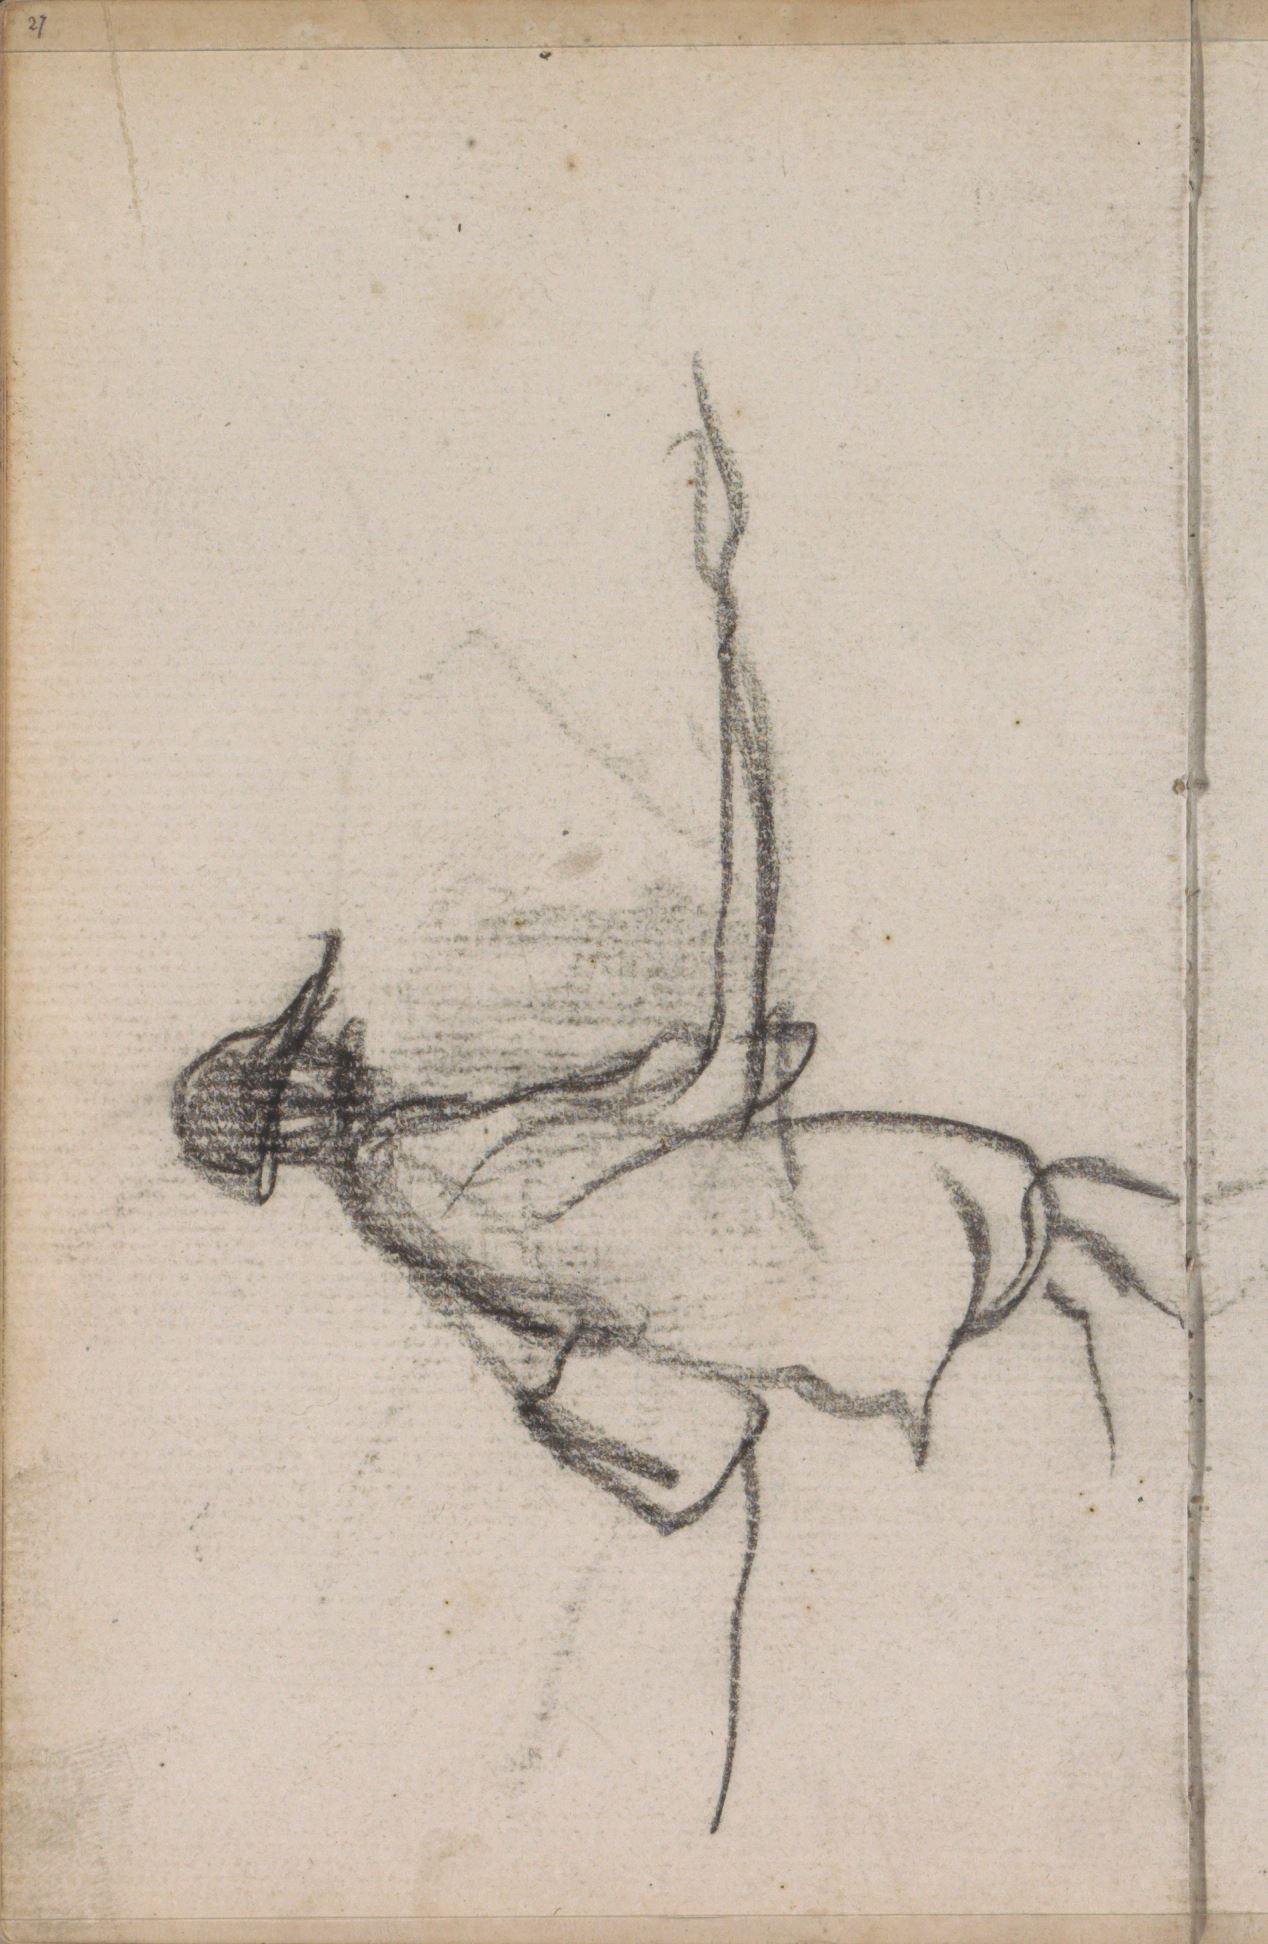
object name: sketchbook leaf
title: Boer, mogelijk zaaiend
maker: george hendrik breitner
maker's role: draughtsman, painter, print maker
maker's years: 1857-1923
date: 1884-1886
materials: chalk, paper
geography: drenthe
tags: farmers, sowing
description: Pagina 27 uit een schetsboek met 67 bladen vervaardigd in Drenthe.